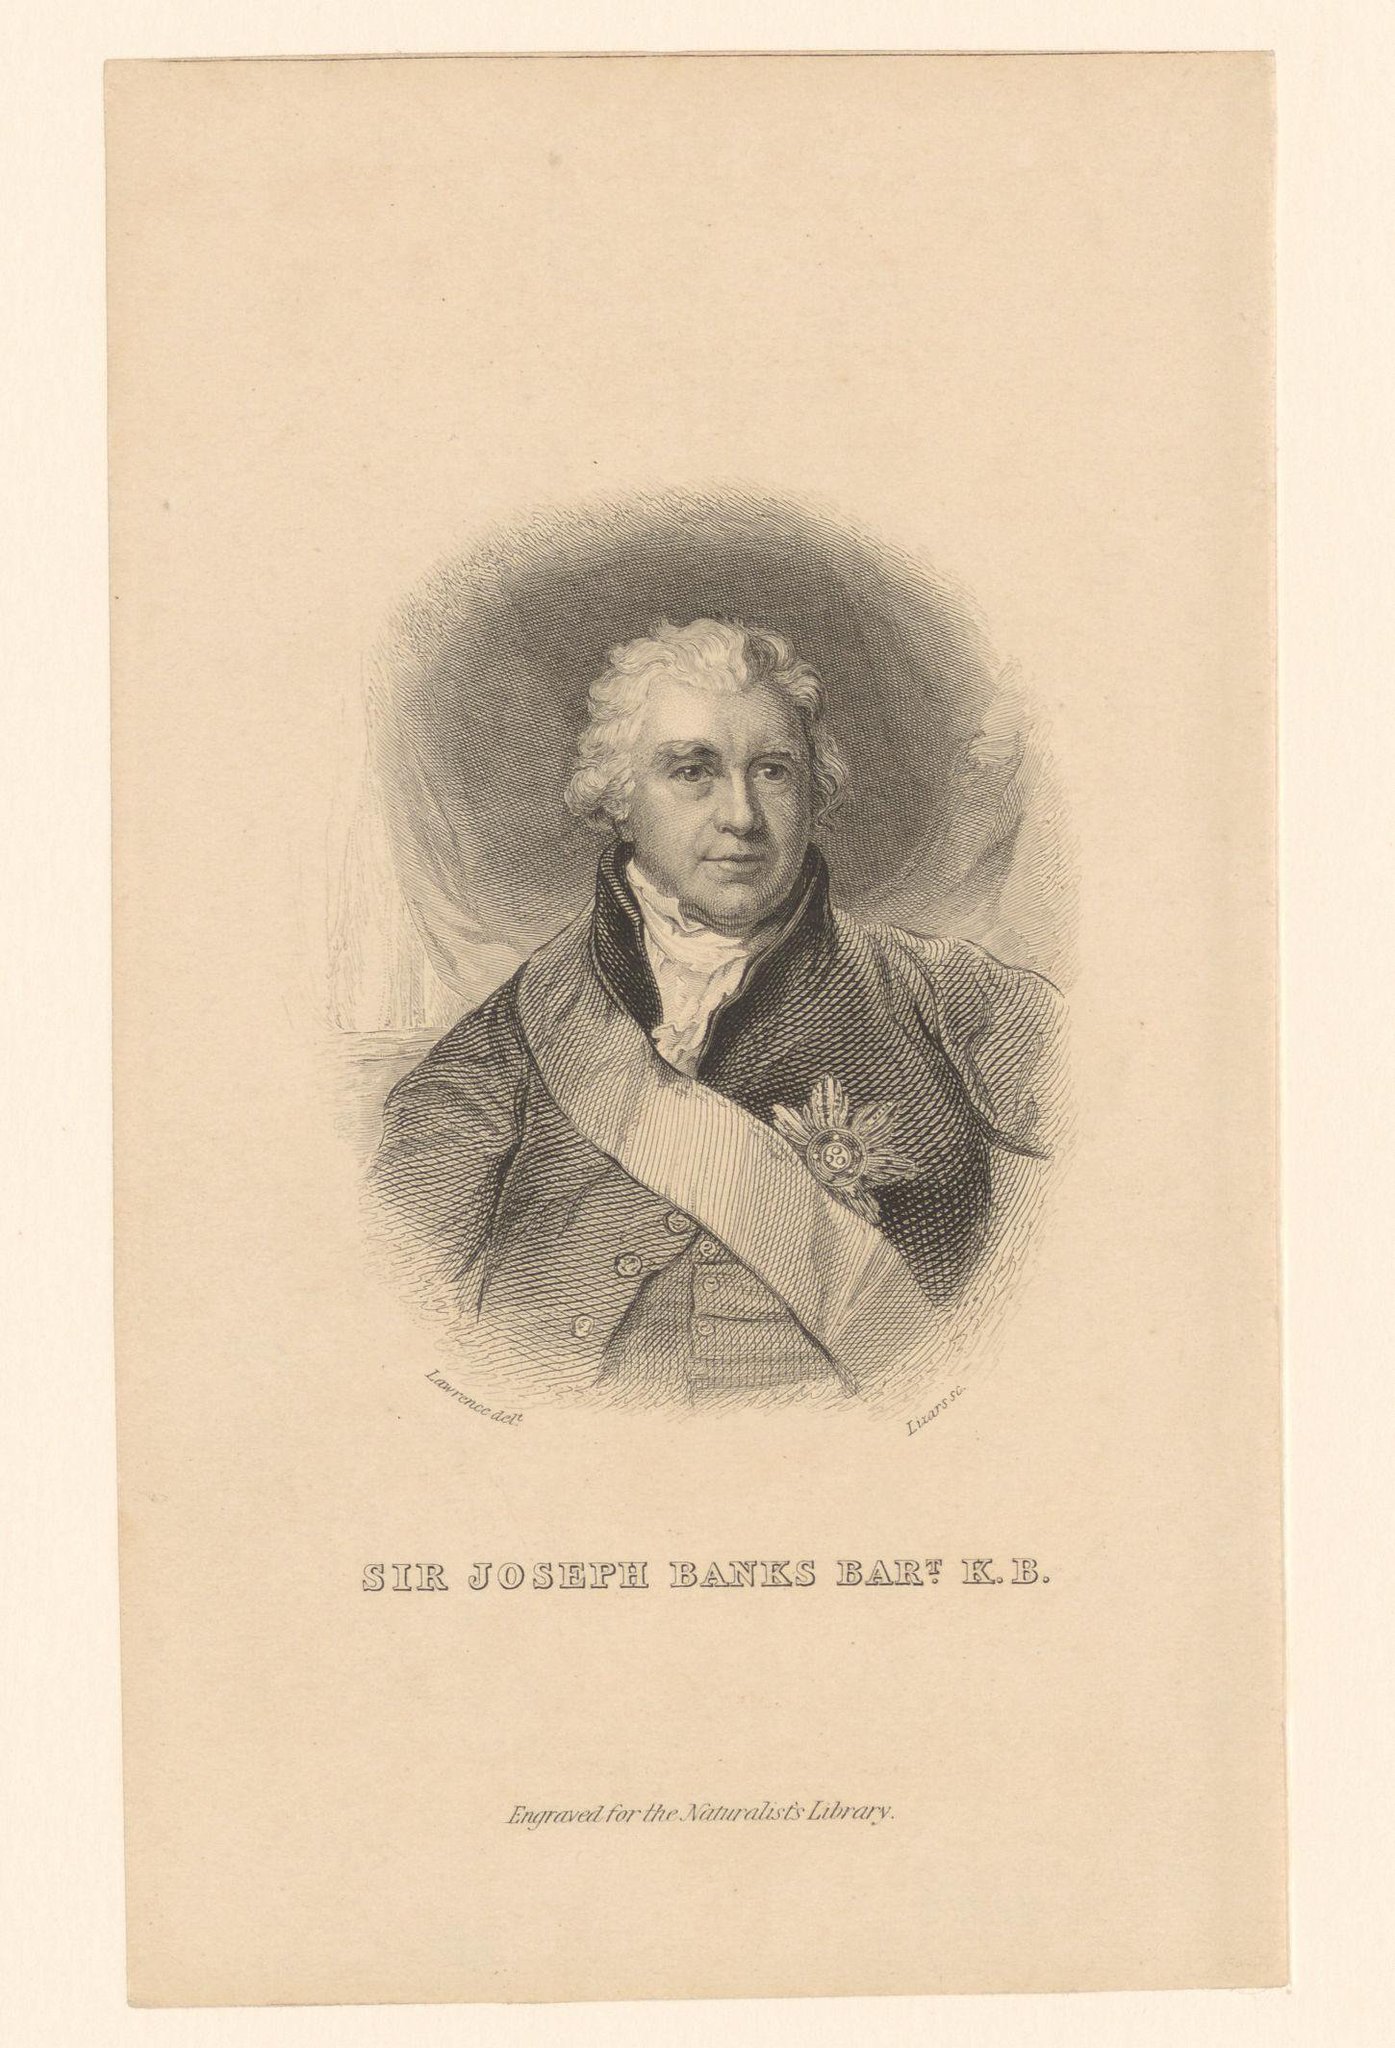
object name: print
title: Portret van Joseph Banks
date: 1798-1859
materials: paper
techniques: engraving, etching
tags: joseph banks, botany (+ portrait of scholar, scientist), historical persons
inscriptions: collector's mark: Lugt 2228